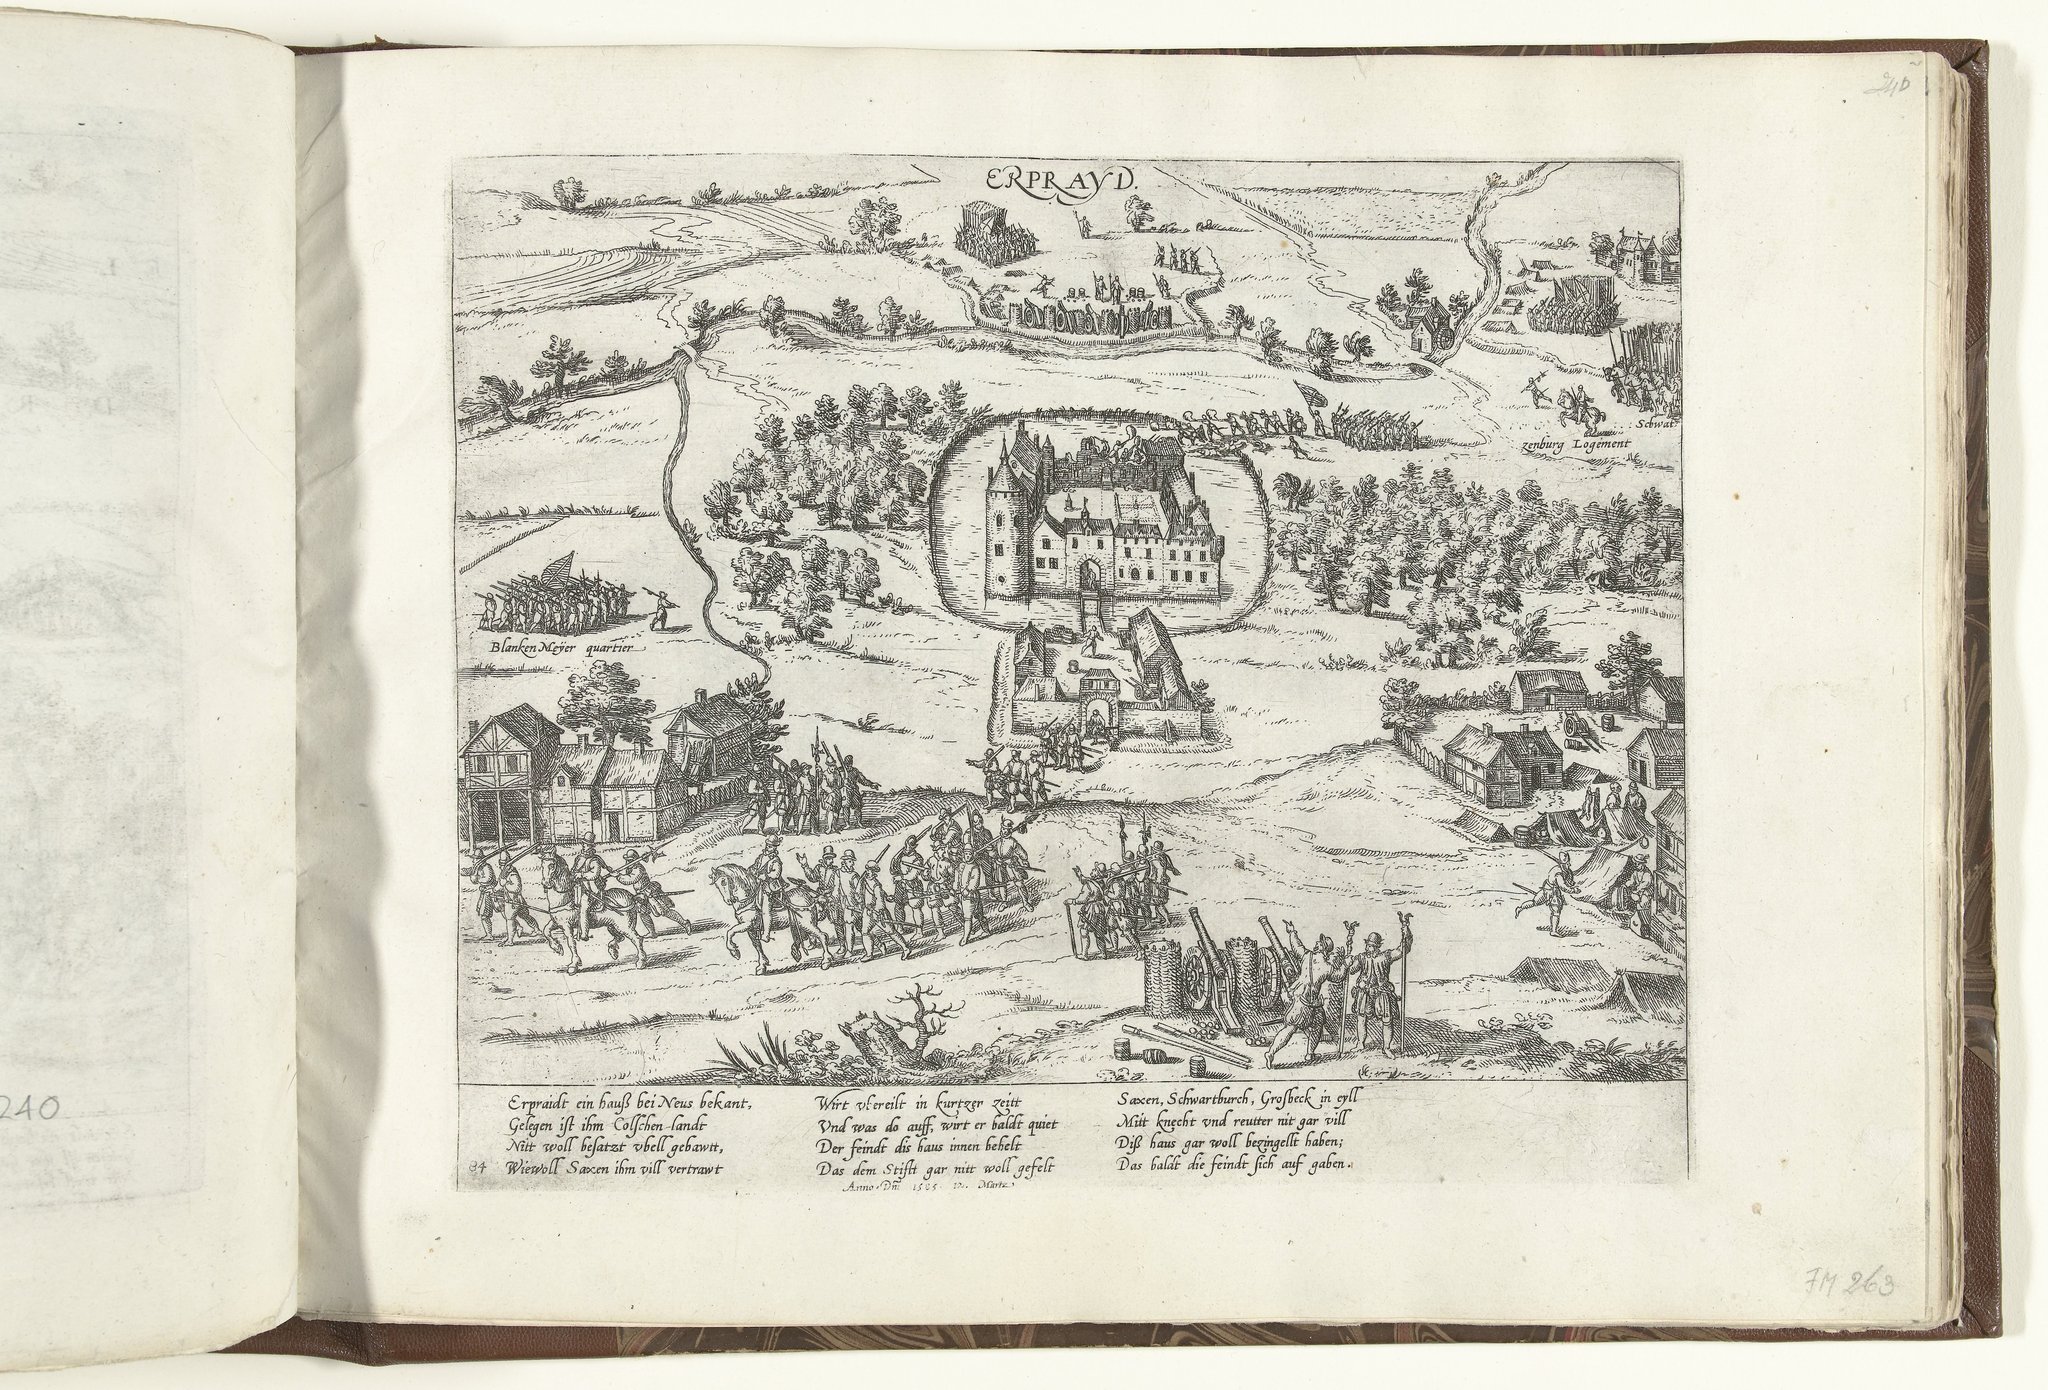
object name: print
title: Aftocht van de hertog van Saksen uit Schloss Erprath, 1585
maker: frans hogenberg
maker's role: print maker, publisher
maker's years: 1538-1590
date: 1585-1587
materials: paper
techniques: etching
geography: cologne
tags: capture of city (after the siege)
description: Aftocht van de hertog van Saksen uit Schloss Erprath, 12 maart 1585. Episode uit de Keulse Oorlog. Met onderschrift van 12 regels in het Duits. Genummerd: 84.